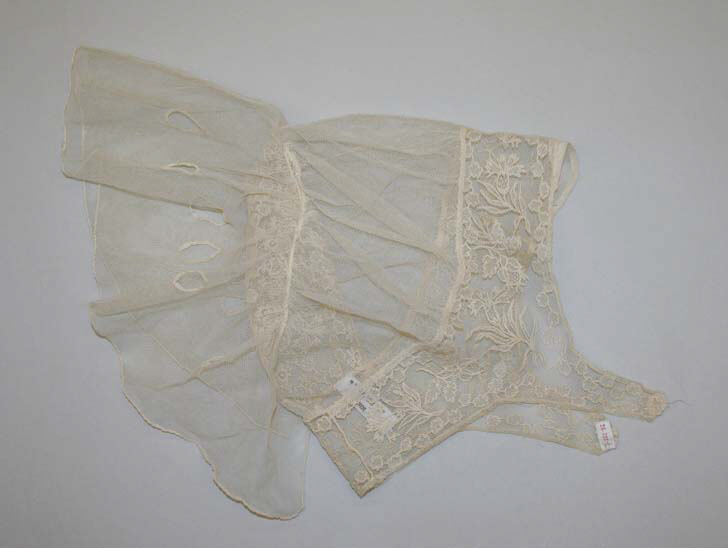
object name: cap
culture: american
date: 1815-1820